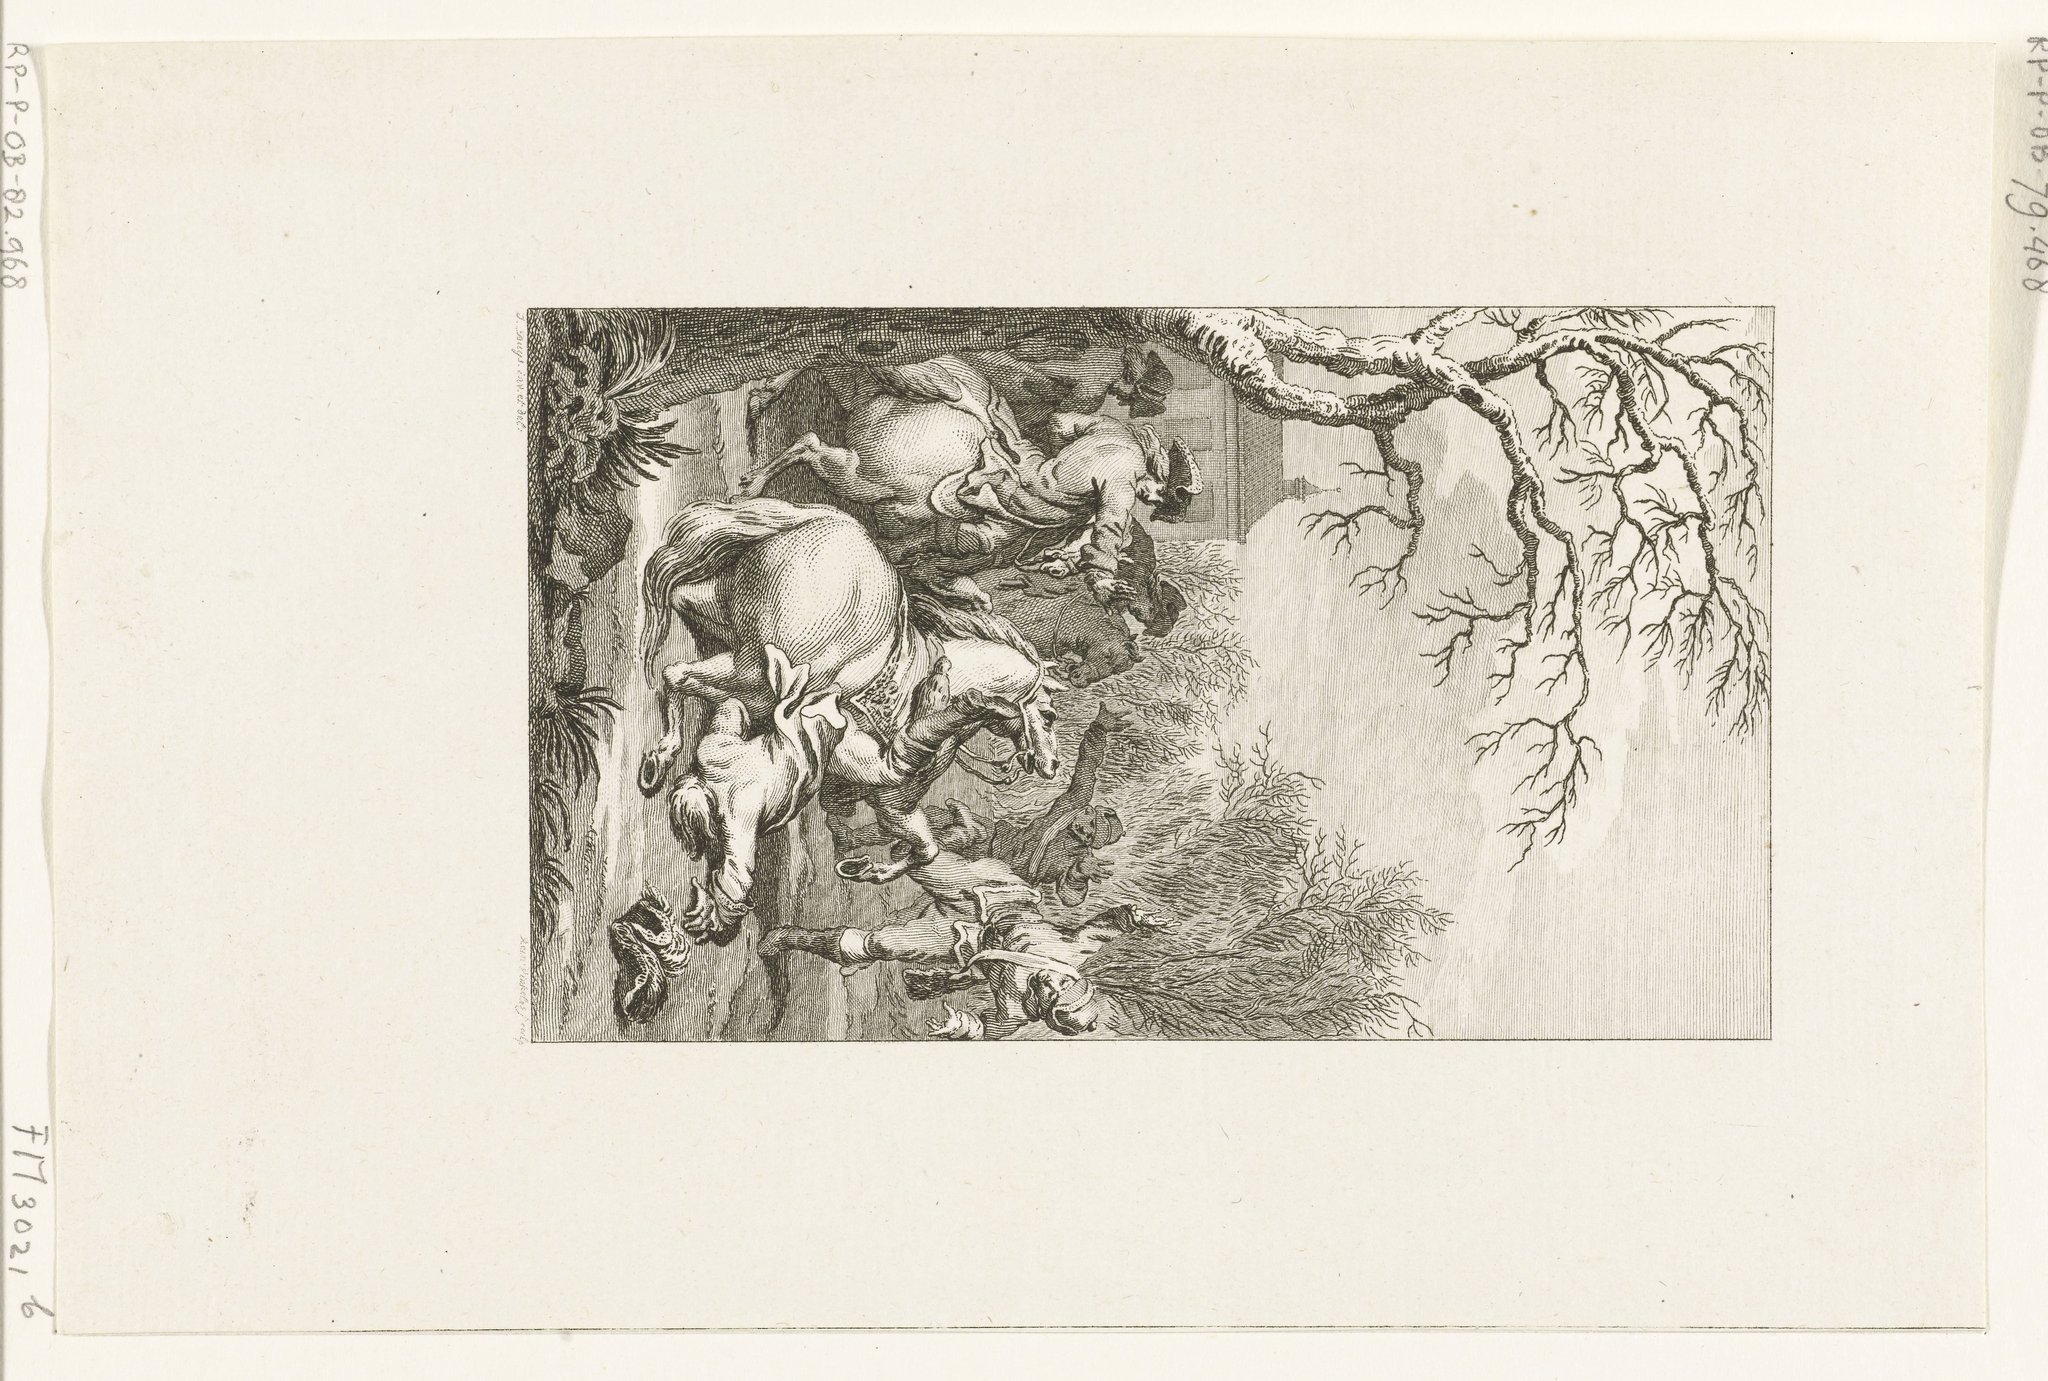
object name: print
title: De dodelijke val van Willem III tijdens een jachtpartij, 1702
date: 1794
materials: paper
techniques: etching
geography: northern netherlands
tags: william iii (prince of orange and king of england, scotland, and ireland), hunting accidents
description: Gebruikt als illustratie in: Jacobus Kok, Vaderlandsch Woordenboek, Johannes Allart, Amsterdam 1785-1799, 35 delen, dl. XXXII, pl. I. Herbegruik van de plaat van de val Hans Willem, baron van Aylva, 1691 (FMH 2841).